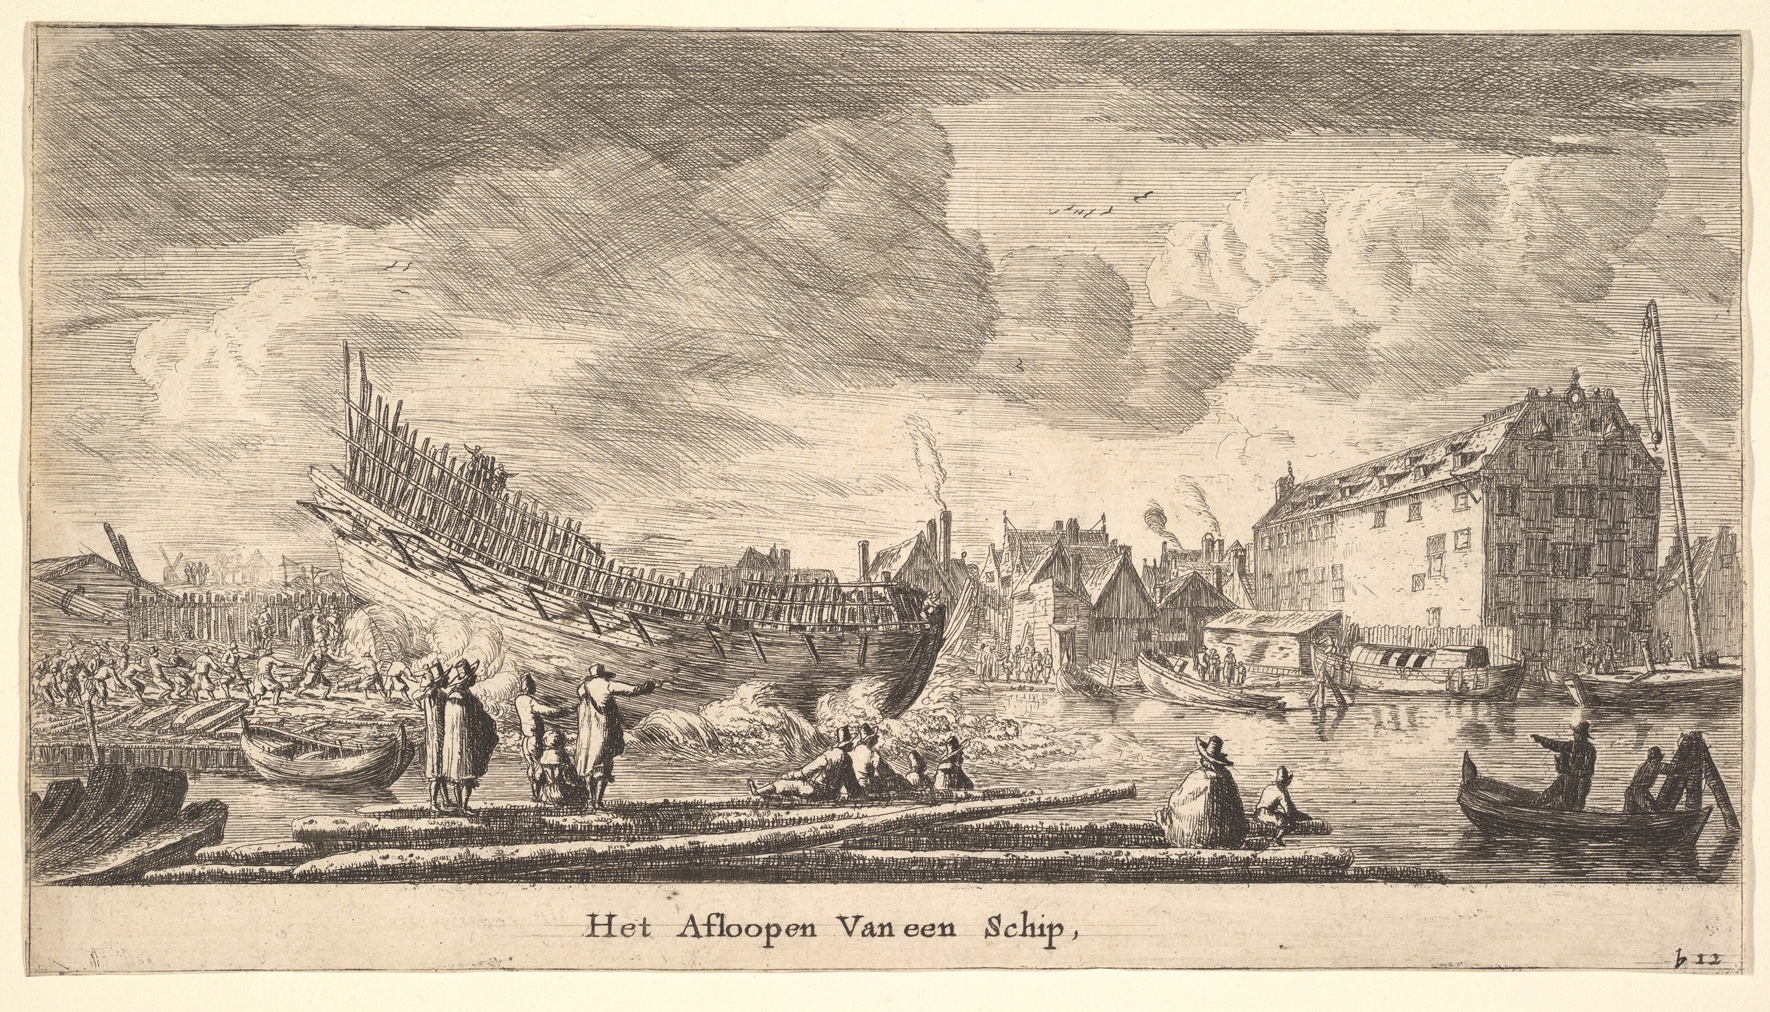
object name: print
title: The Launch of a Ship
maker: reinier nooms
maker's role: artist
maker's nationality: dutch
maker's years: 1623-1664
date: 1601-1700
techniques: drypoint, etching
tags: human figures,buildings,boats,ships